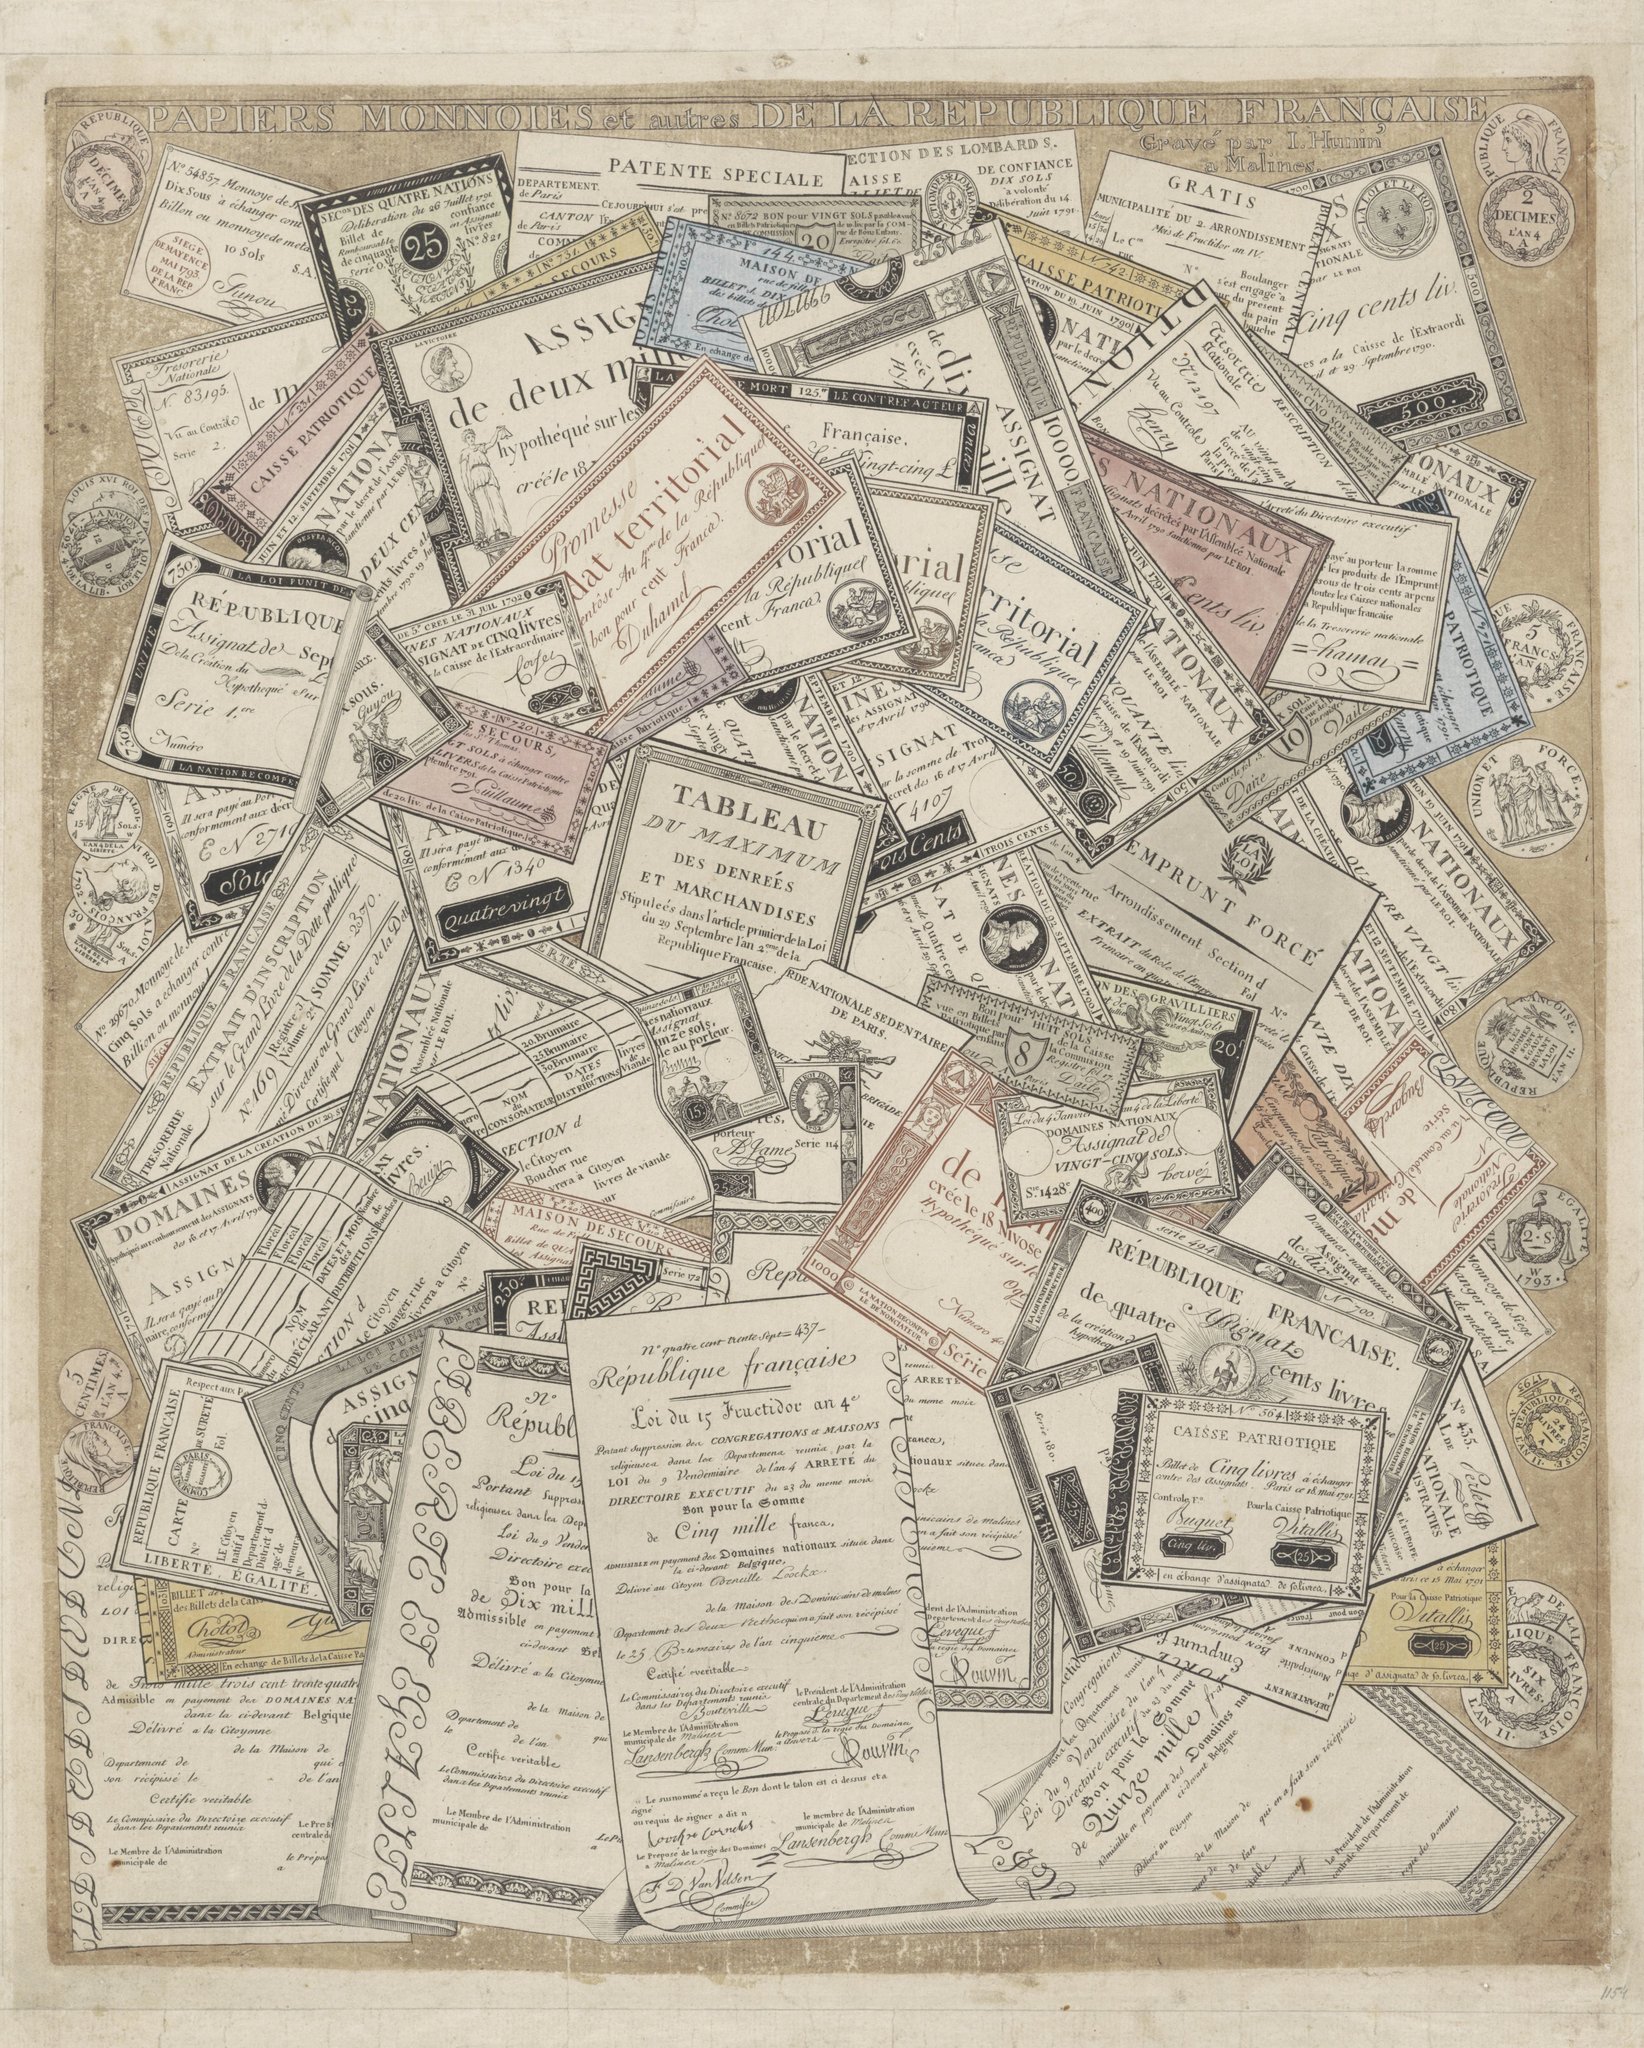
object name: print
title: Frans papiergeld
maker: joseph hunin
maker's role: print maker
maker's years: 1770-1851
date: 1780-1851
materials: paper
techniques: engraving, etching, hand coloring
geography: mechelen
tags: coin, bank-note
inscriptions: collector's mark: Lugt 2228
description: Frans papiergeld en rechts en links aan de zijkant Frans muntgeld.